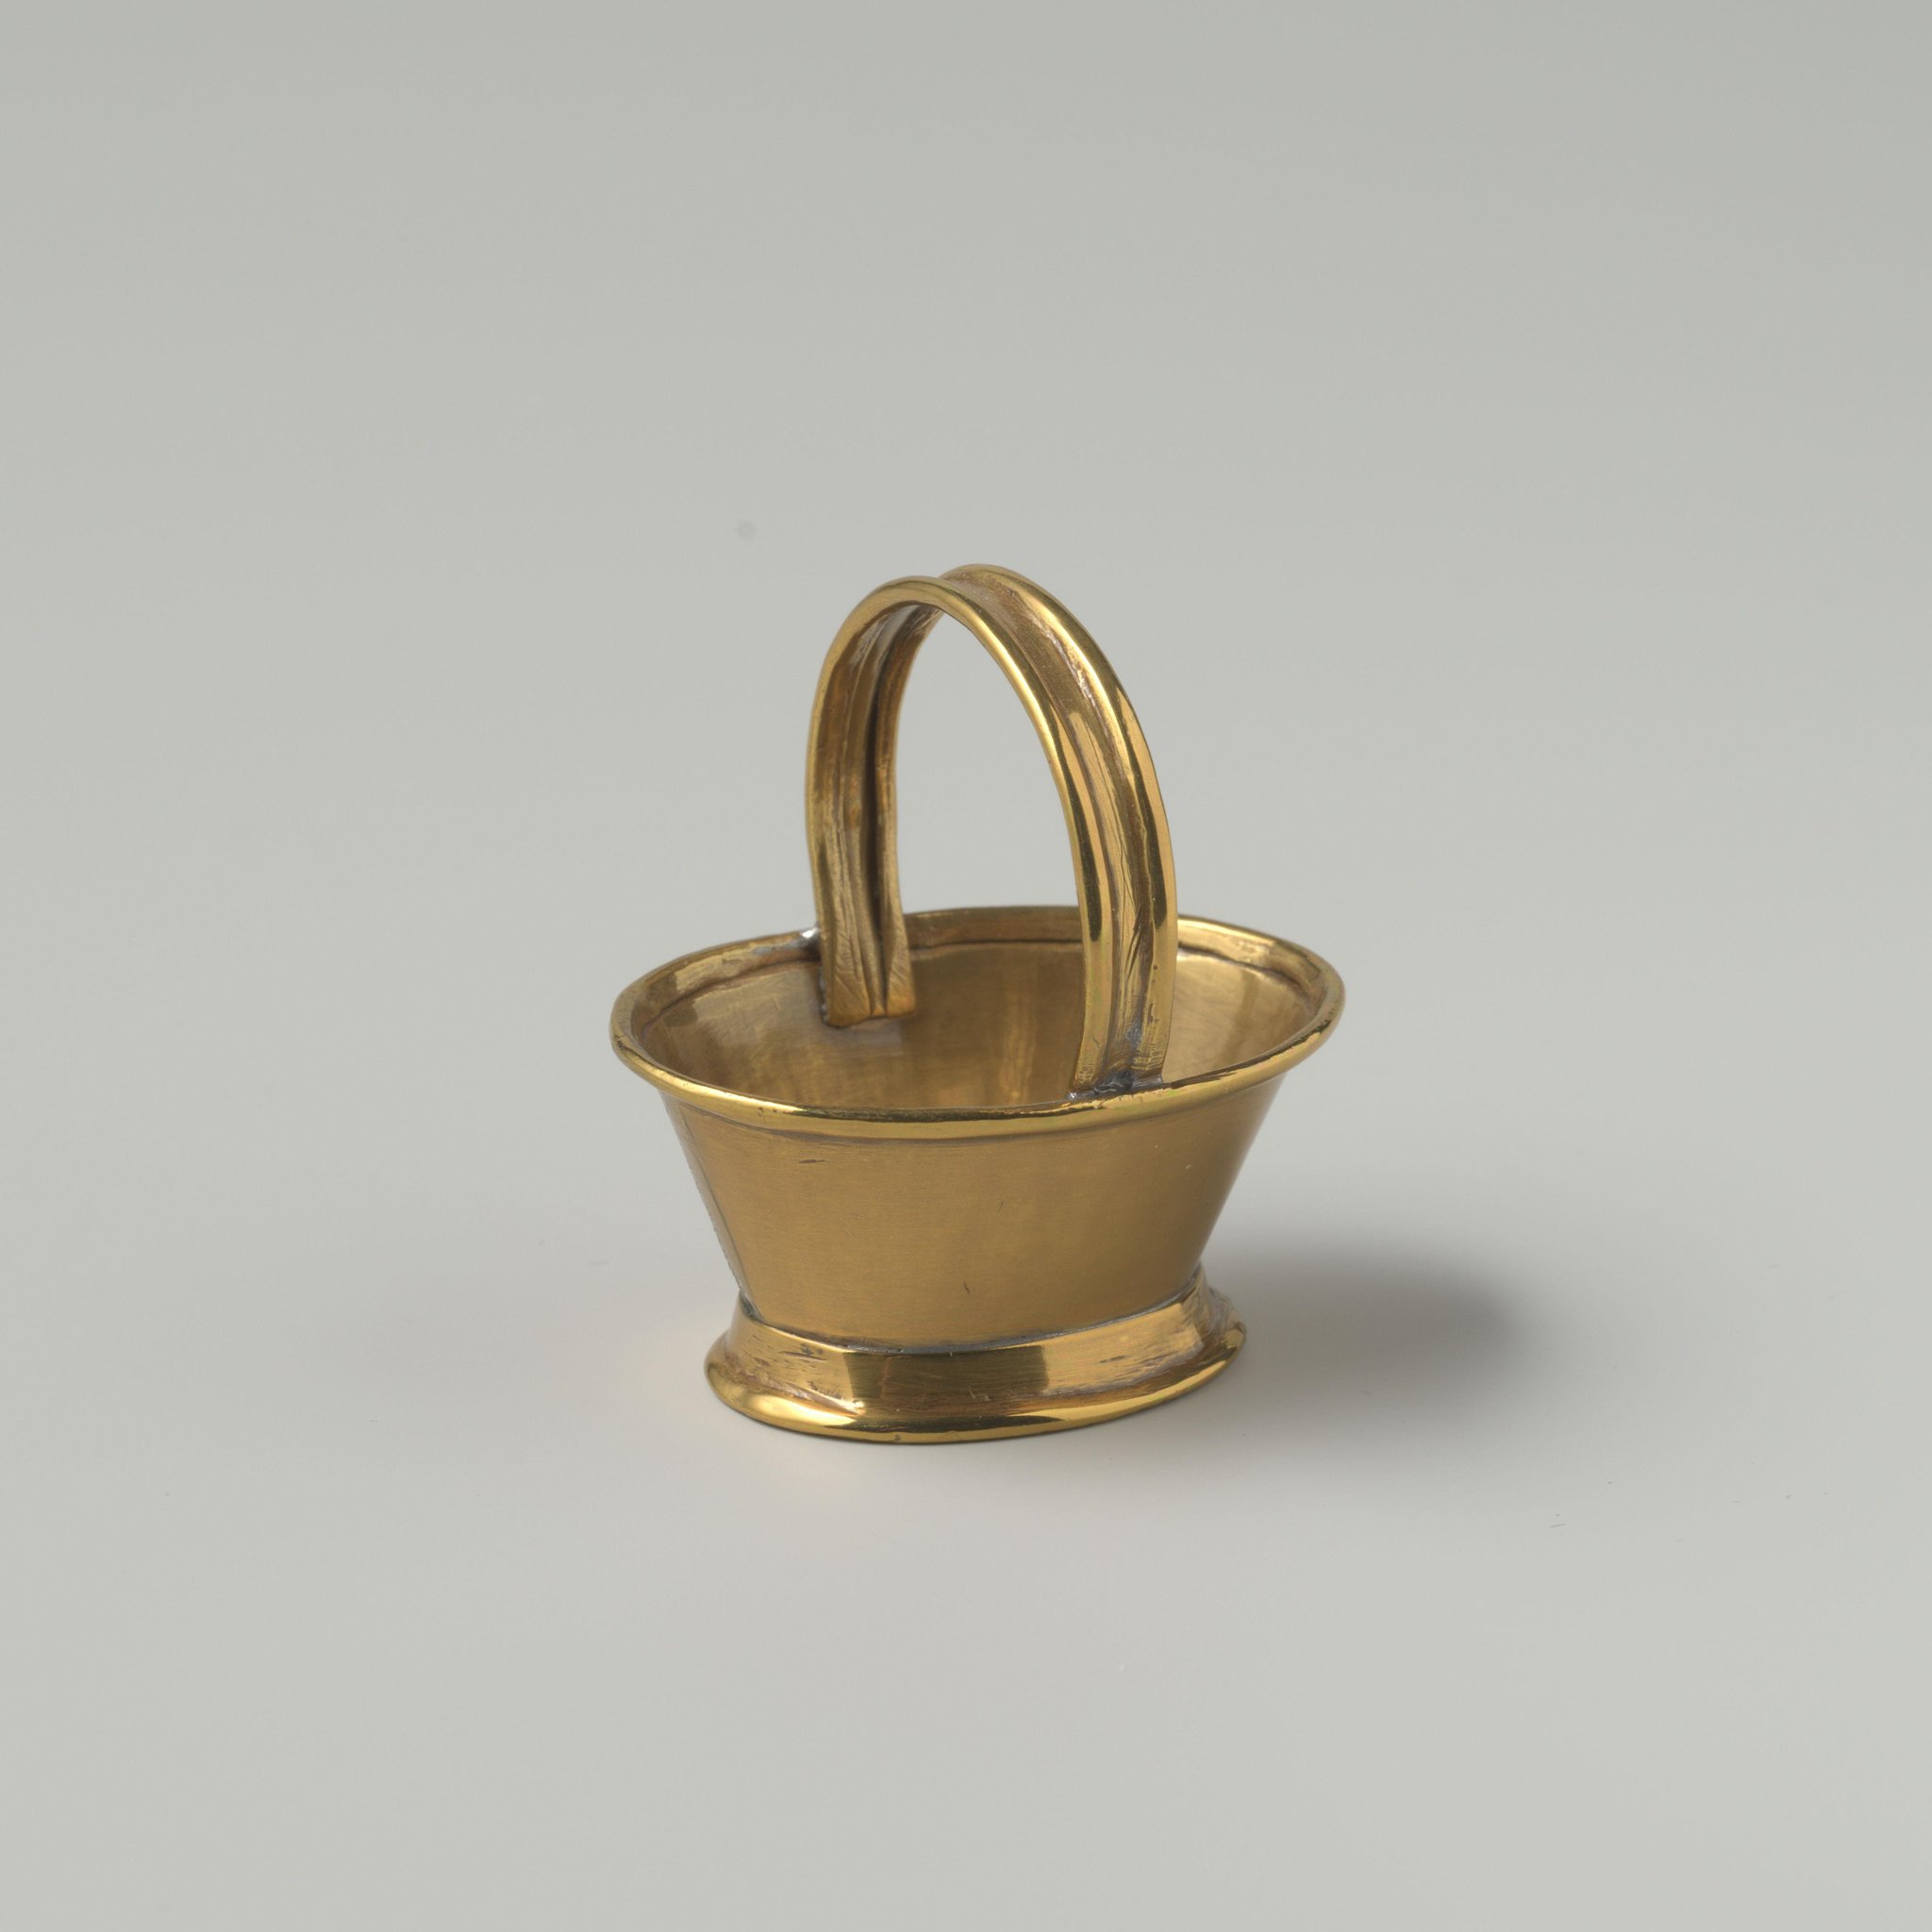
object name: pail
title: Marktemmer van geel koper; ovale, wijd uitlopende hoge bak met vast hengsel, op breed uitlopende standring, alle randen zijn naar binnen omgeslagen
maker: Anonymous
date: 1690-1710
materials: copper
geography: amsterdam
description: Marktemmer van geel koper; ovale, wijd uitlopend lage bak met vast hengsel, op breder uitlopende standring. Alle randen zijn naar binnen omgeslagen.